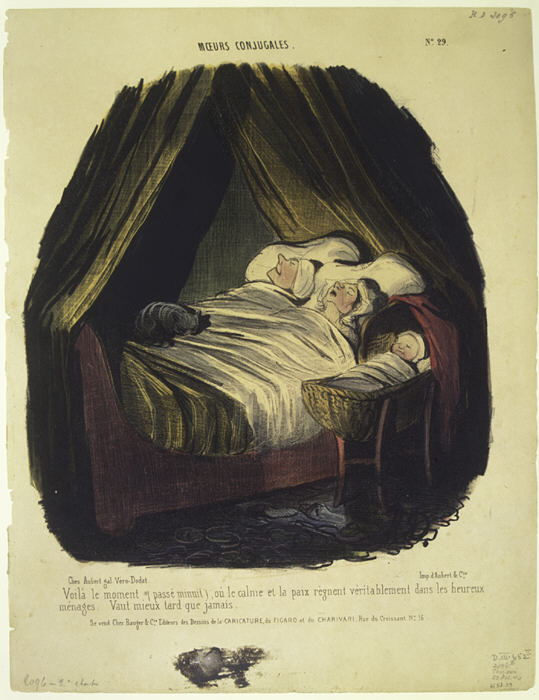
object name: print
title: Voilà le moment (passé minuit), ou le calme et la paix régnent véritablement dans les heureux menages (Moeurs Conjugales, No. 29)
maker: honoré daumier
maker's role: artist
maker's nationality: french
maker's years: 1808-1879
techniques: hand coloring, lithograph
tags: sleeping,infants,men,women